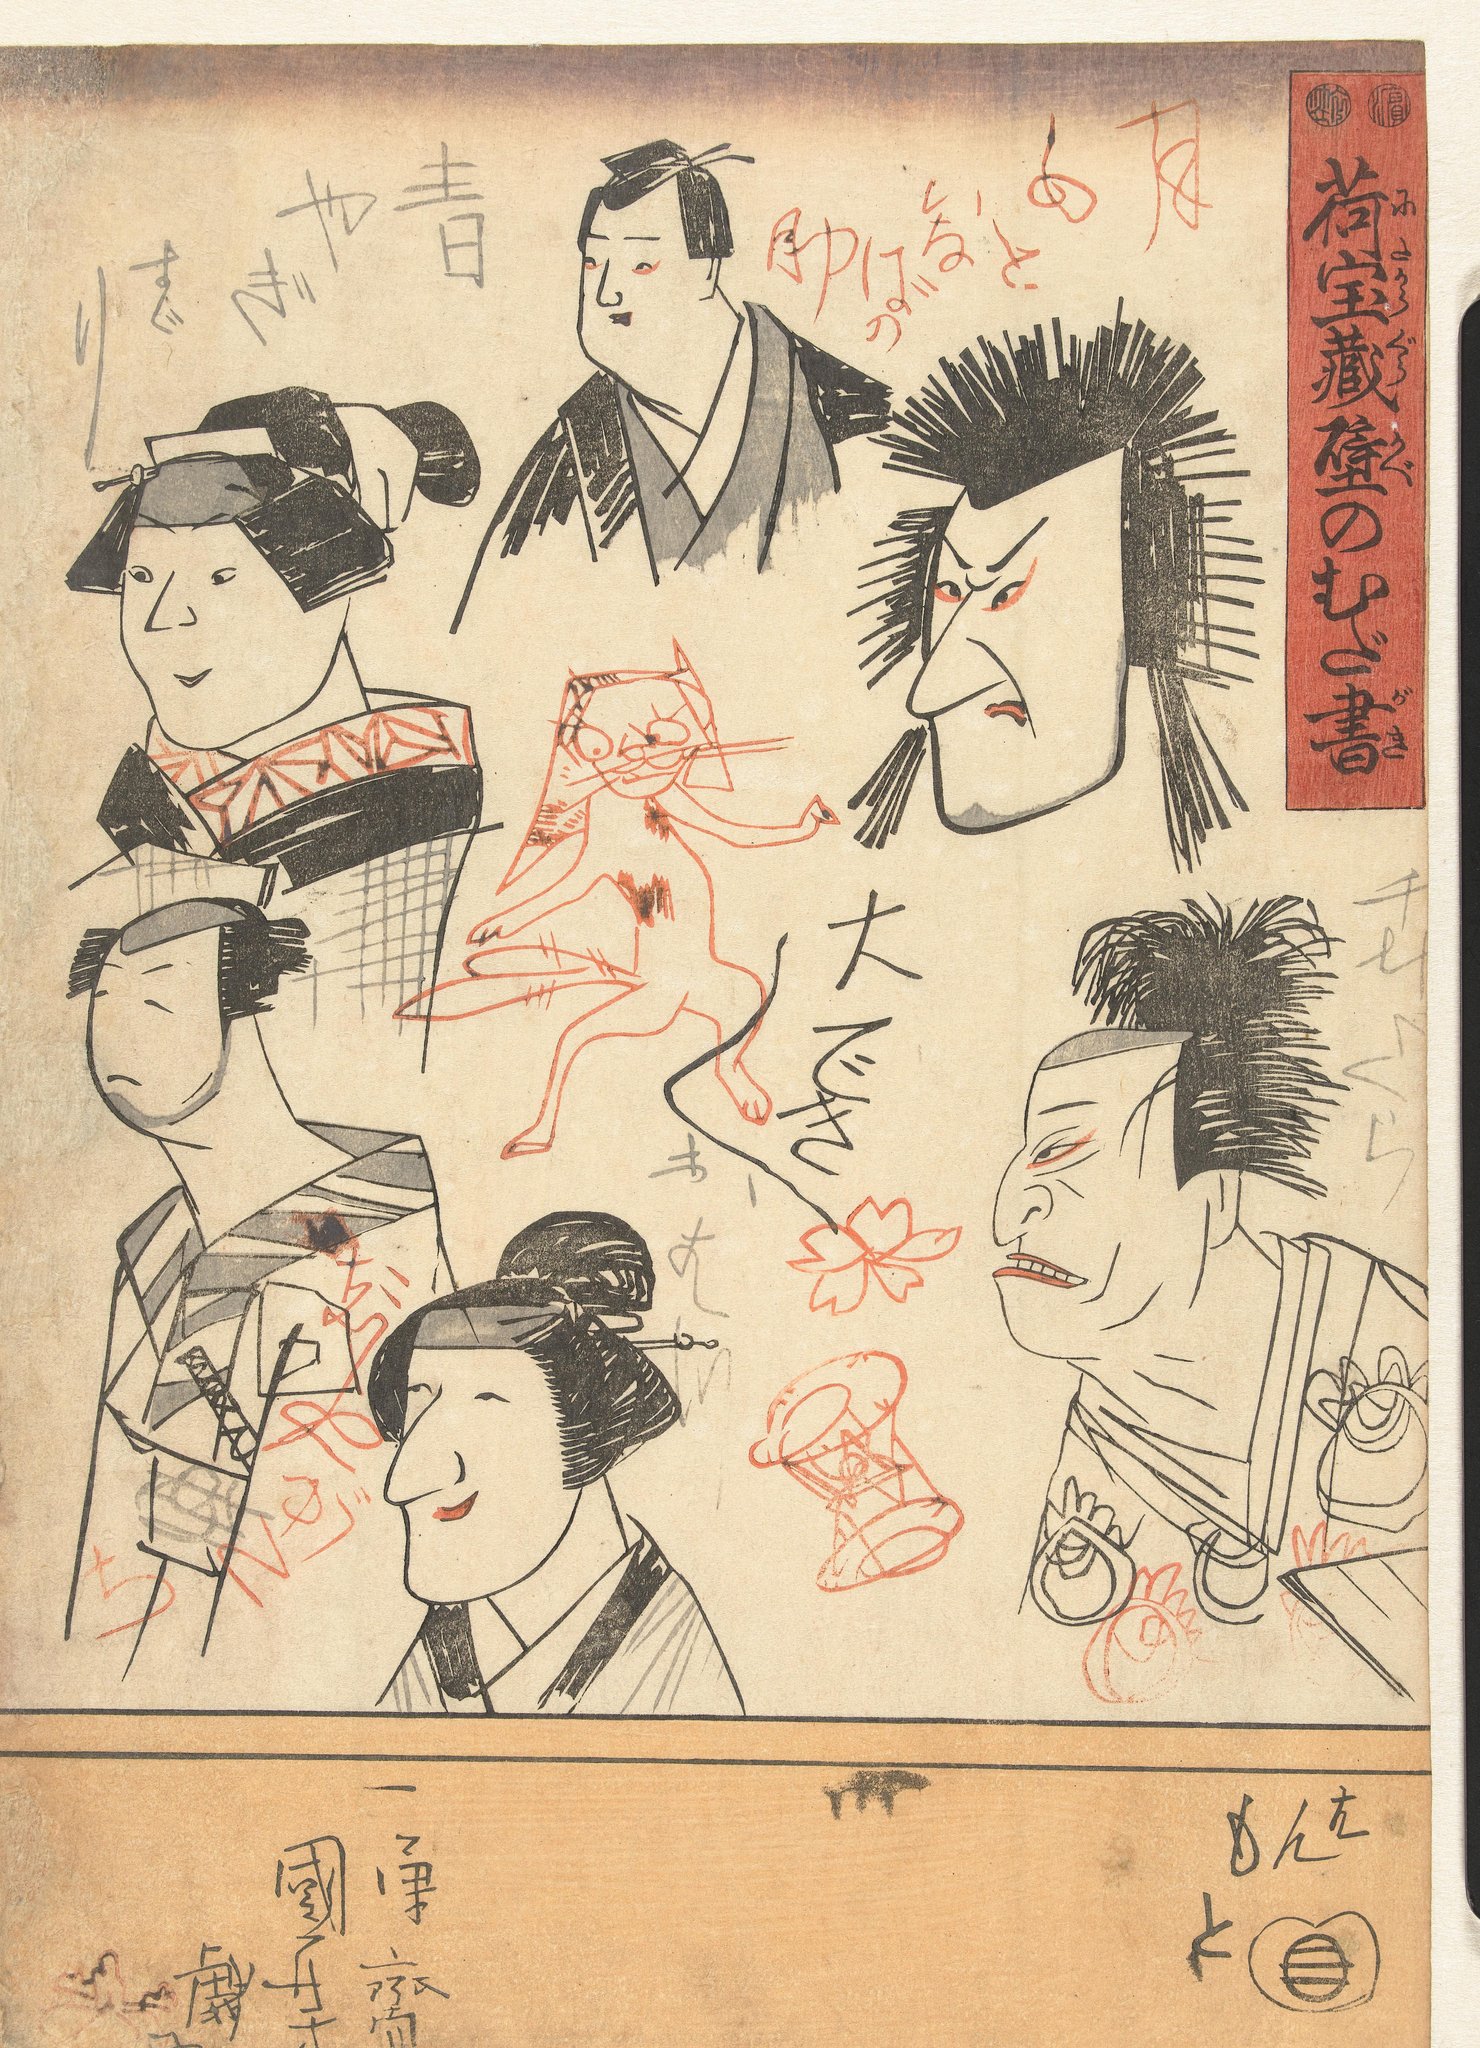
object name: print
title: Zes acteursportretten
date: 1947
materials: paper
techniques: woodcut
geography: japan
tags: cat, portrait of actor, actress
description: Wand waarop graffiti voorstellende zes acteursportretten, een kat en een handtrommel.